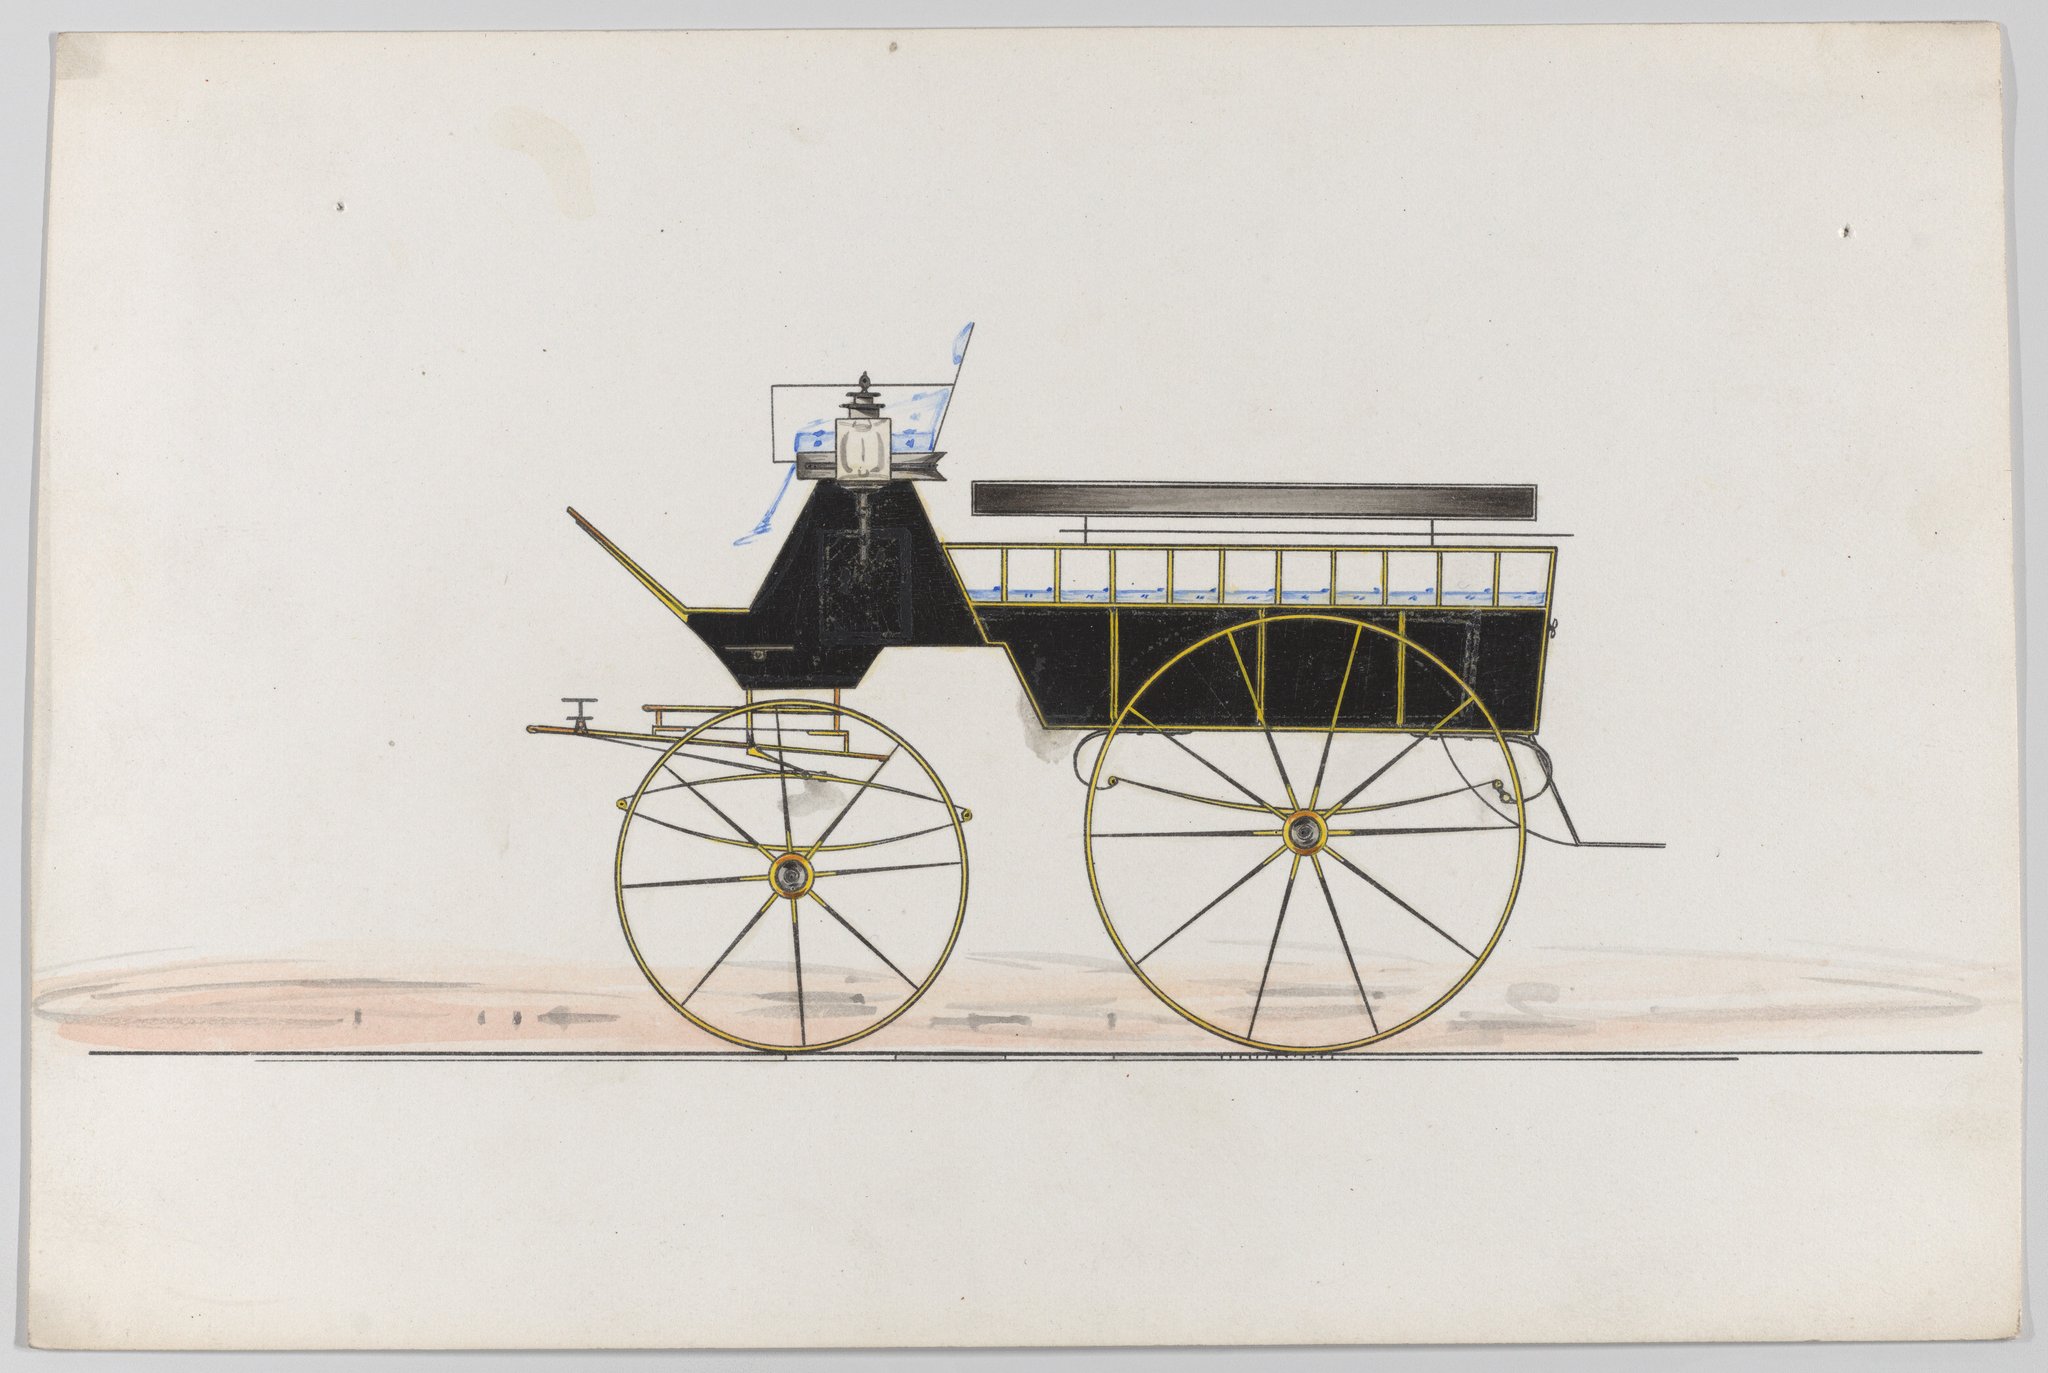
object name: drawing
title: Design for Wagonette (unnumbered)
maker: brewster & co.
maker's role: manufacturer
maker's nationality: american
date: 1870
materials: gouache, gum arabic, ink, watercolor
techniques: pen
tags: carriages